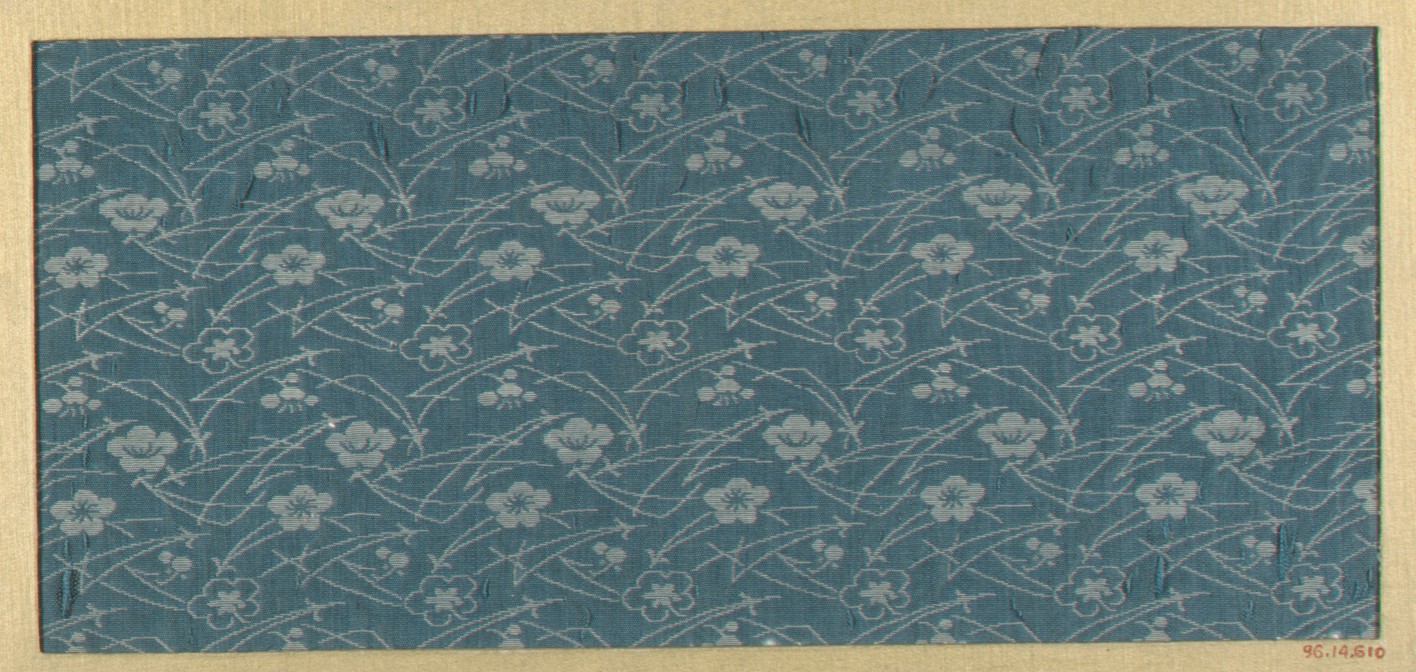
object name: piece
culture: japanese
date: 1701-1900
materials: silk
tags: flowers